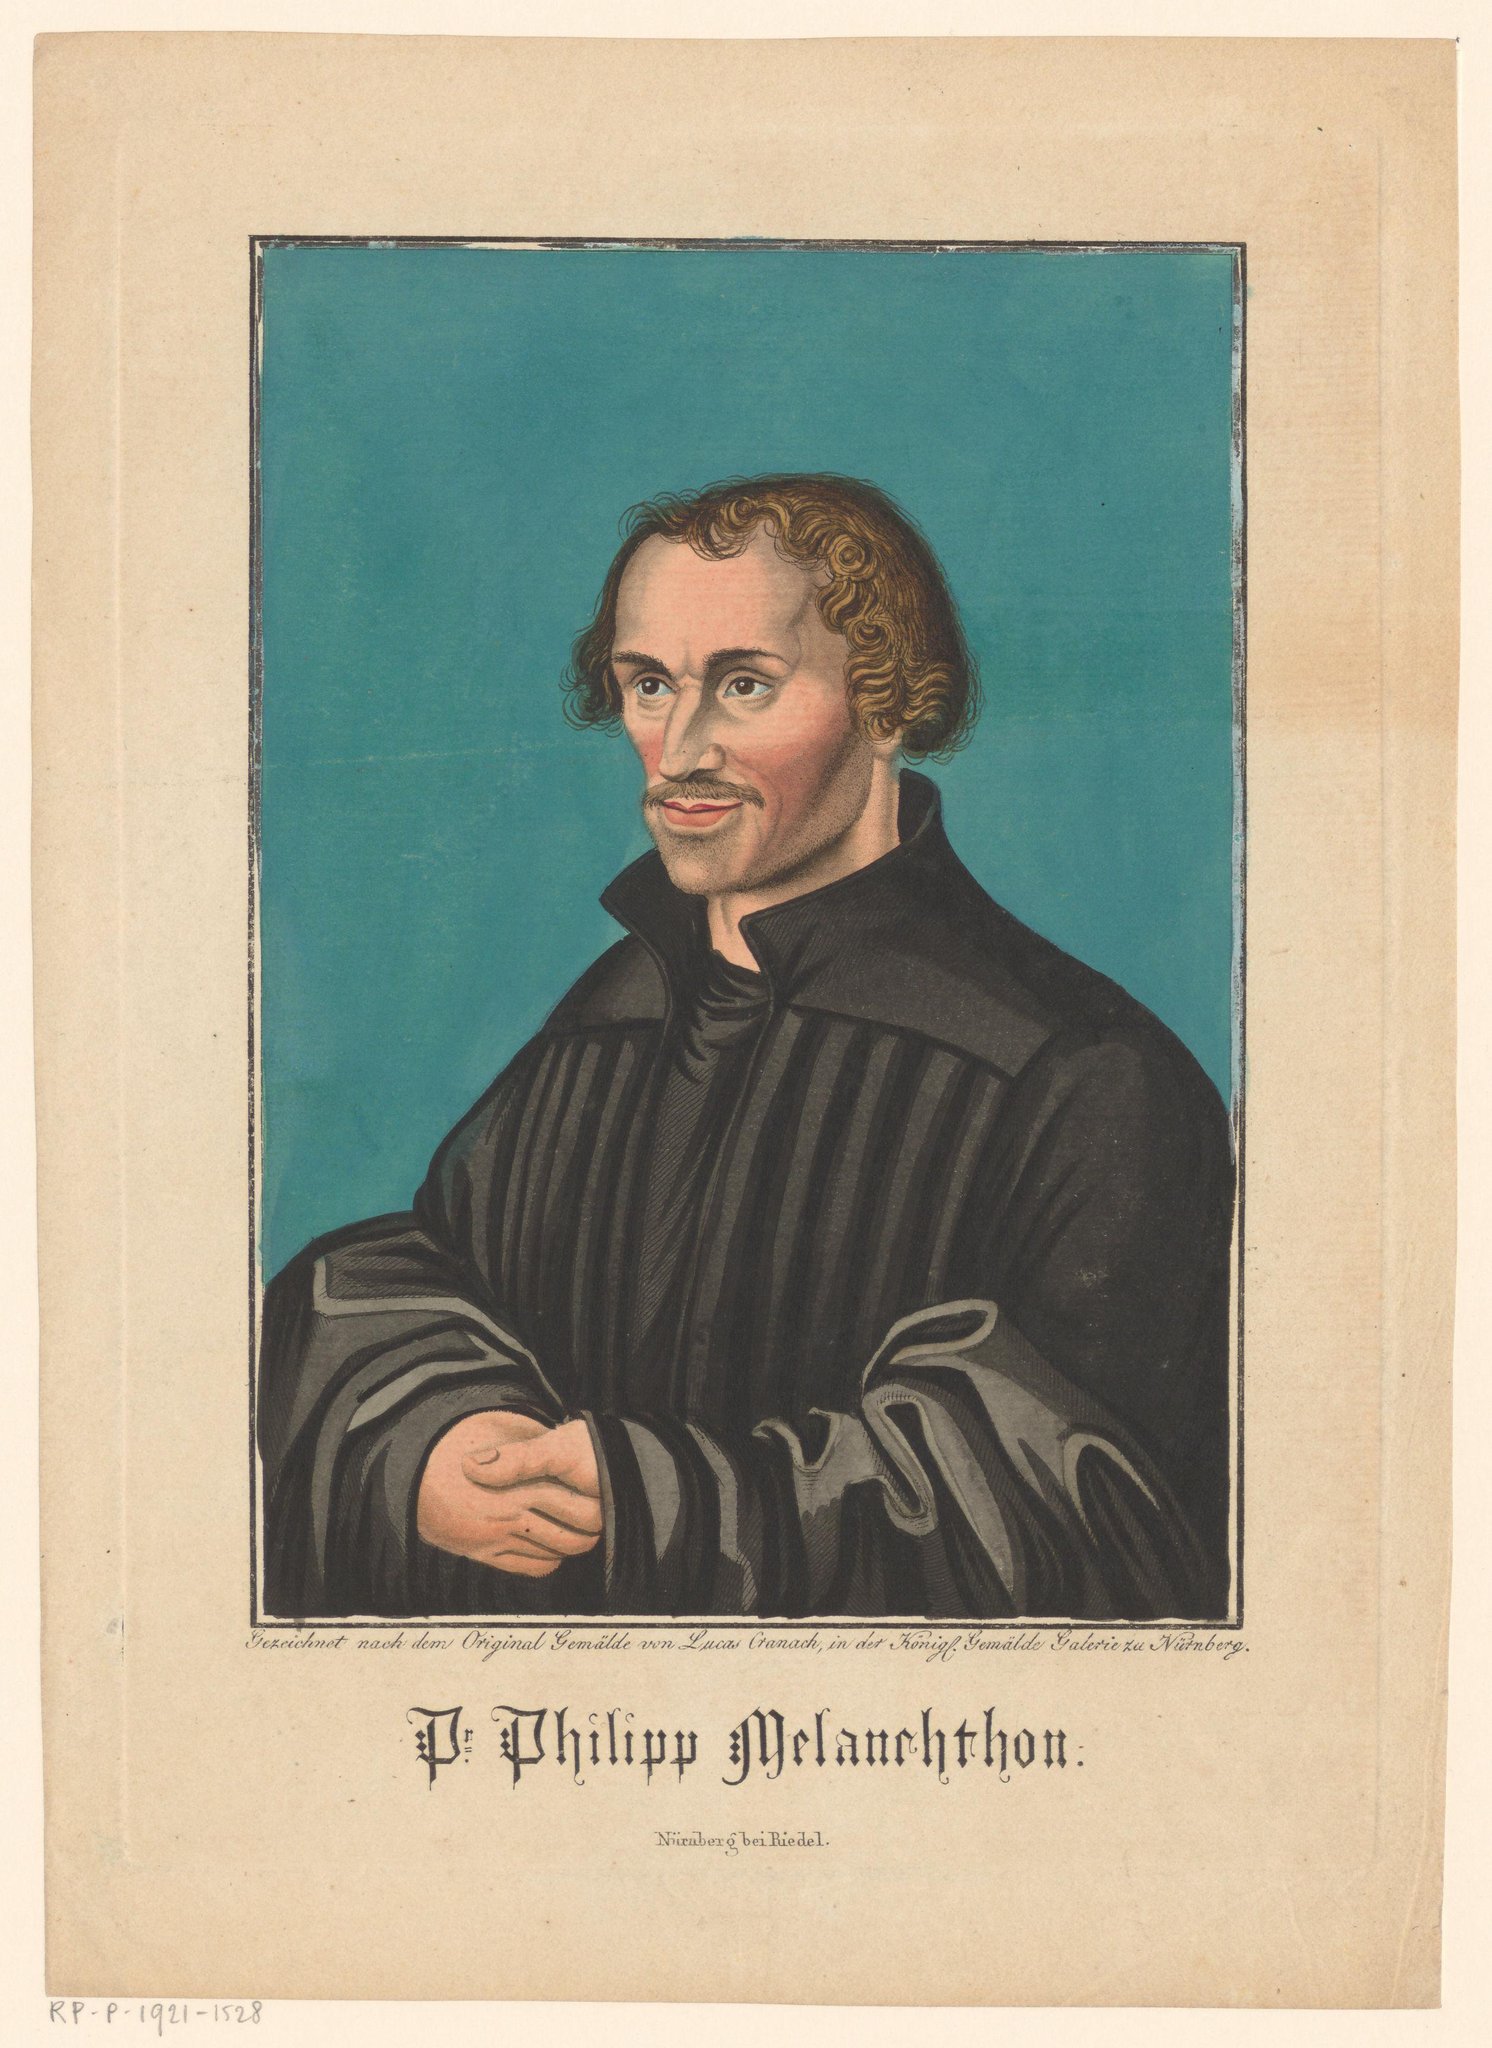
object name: print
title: Portret van Philipp Melanchthon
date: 1800-1900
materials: paper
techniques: hand coloring, lithograph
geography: nuremberg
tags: theologian, historical persons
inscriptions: collector's mark: Lugt 2233